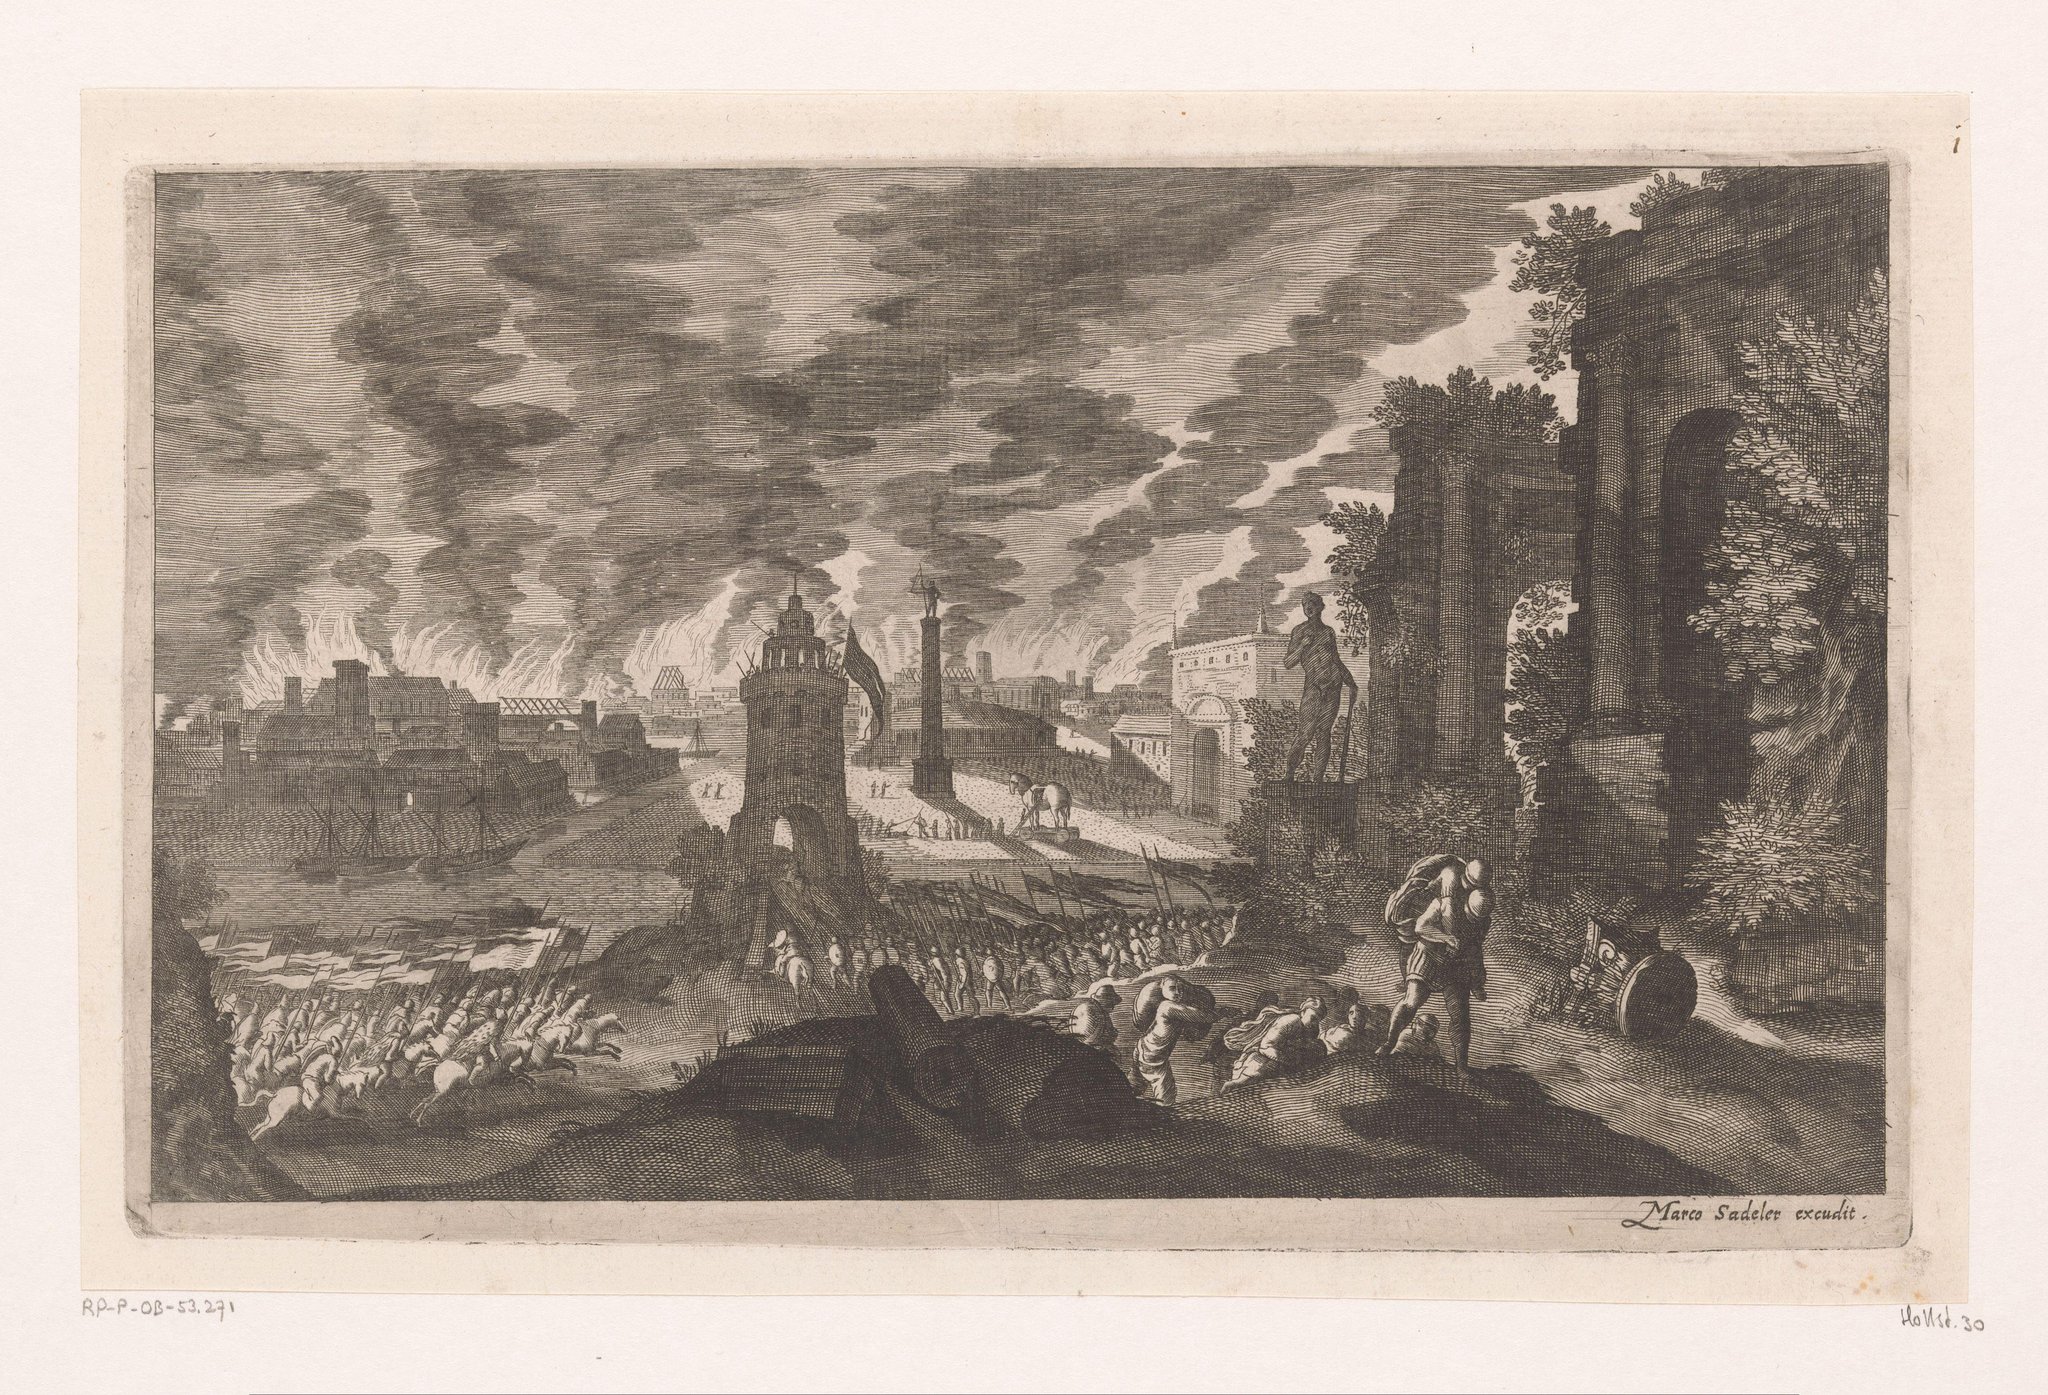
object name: print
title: Aeneas en Anchises ontvluchten Troje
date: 1586-1630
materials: paper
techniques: engraving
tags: 'pius aeneas': aeneas, leading ascanius, escapes from burning troy, carrying his father anchises with the penates; his wife creusa, who sets out with them, is lost on the way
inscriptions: collector's mark: Lugt 240